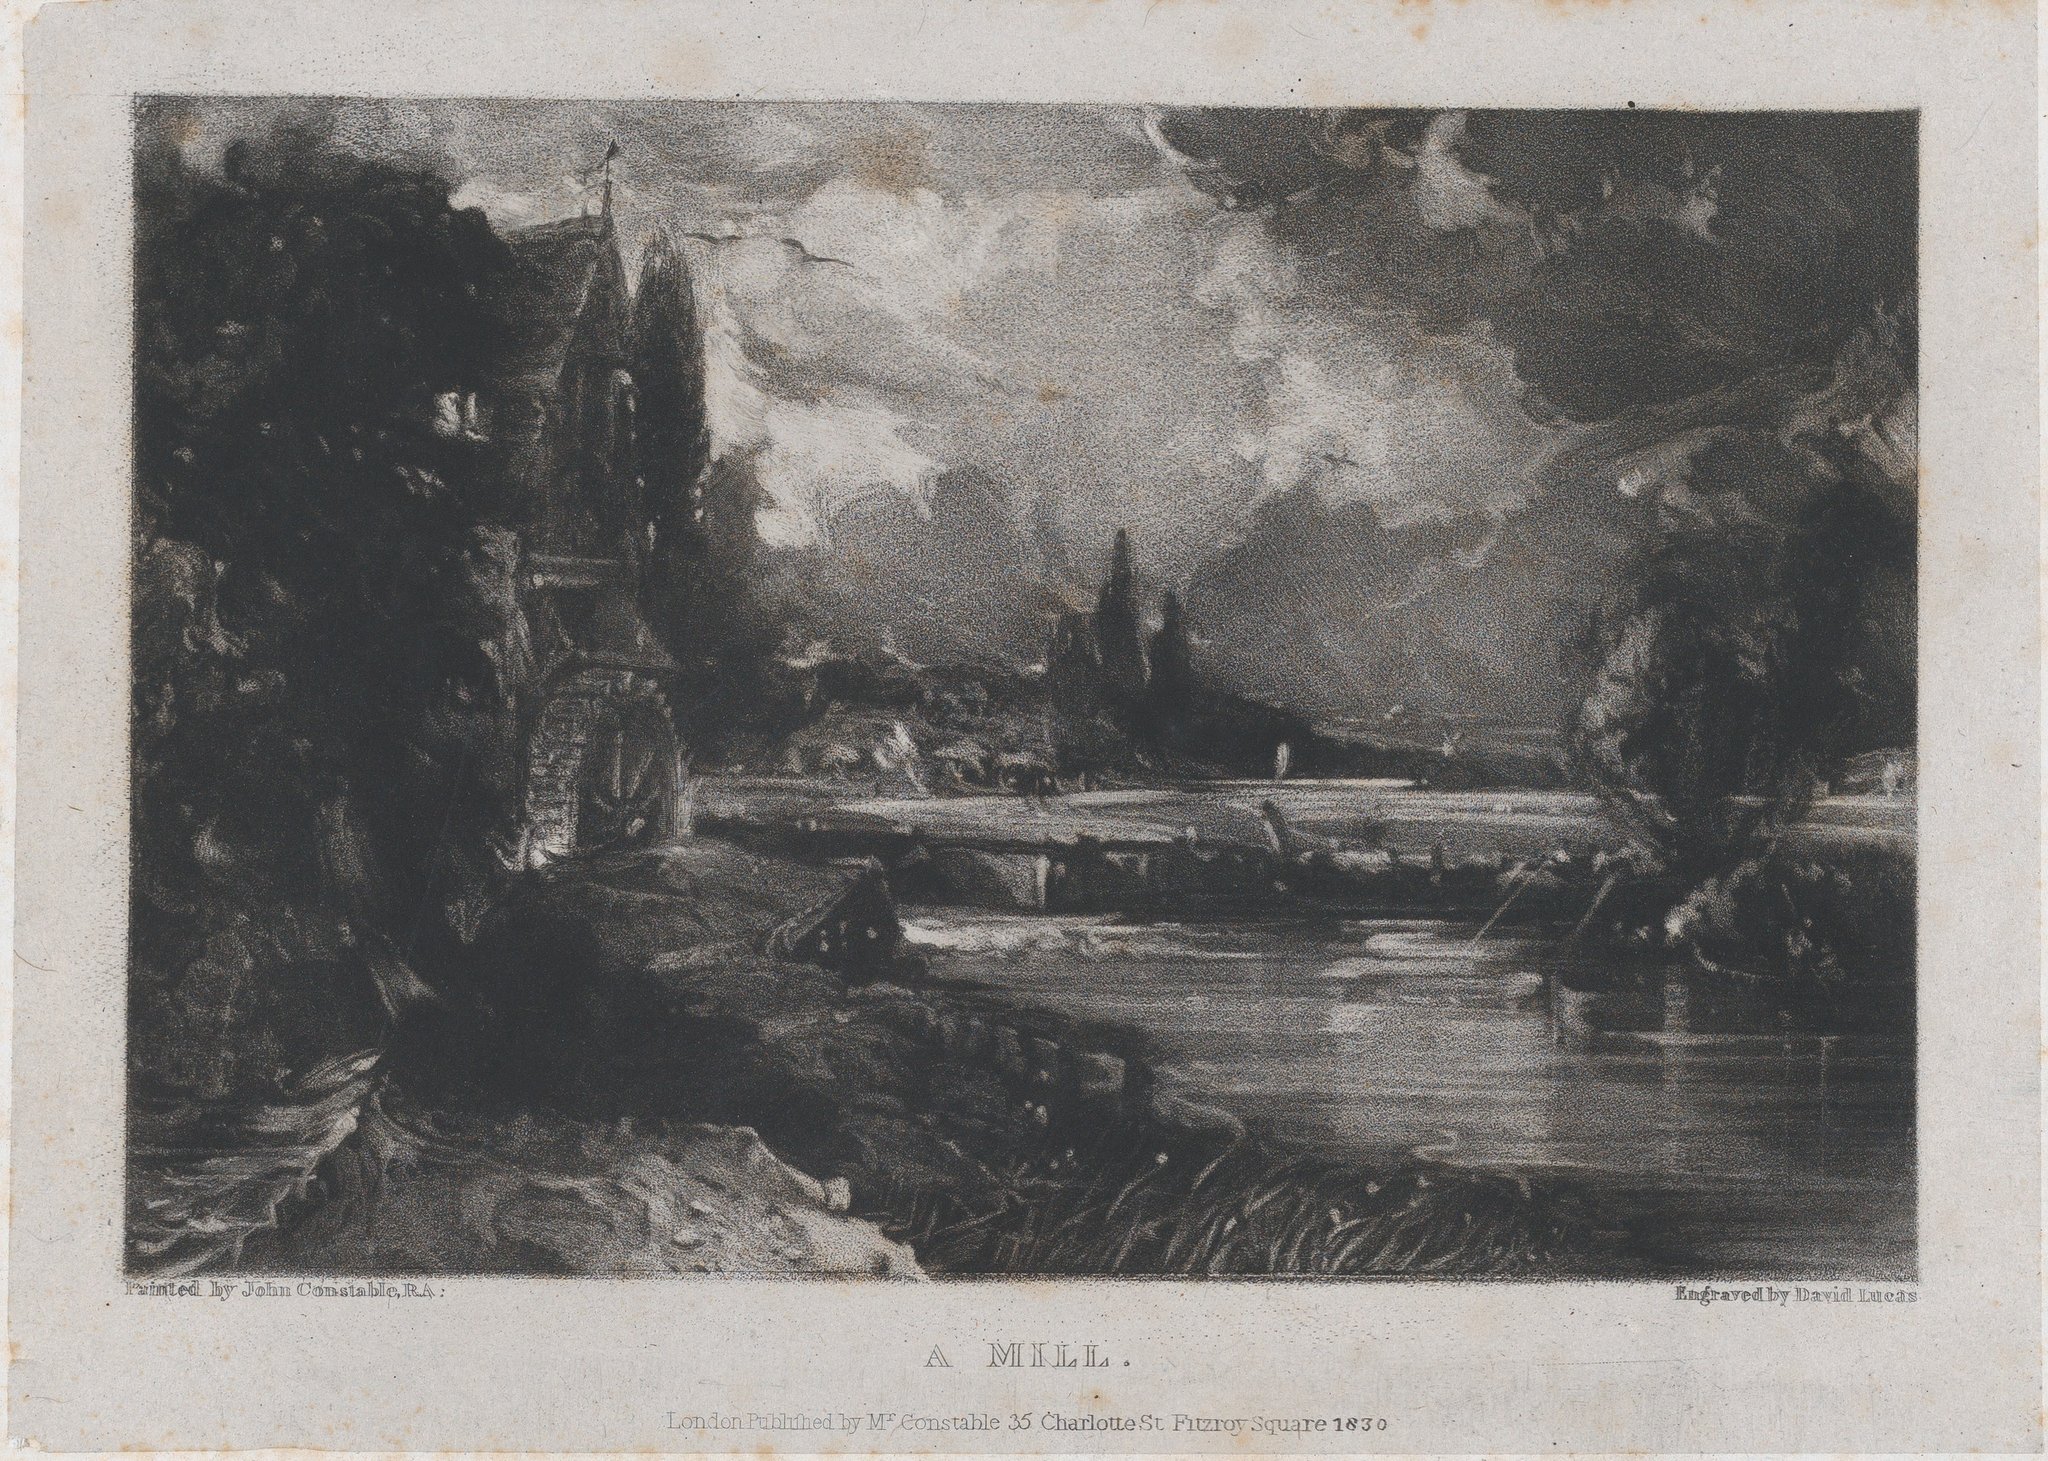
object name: print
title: A Mill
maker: david lucas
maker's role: artist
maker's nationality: british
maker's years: 1802-1881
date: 1830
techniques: printmaking, mezzotint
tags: watermills,landscapes